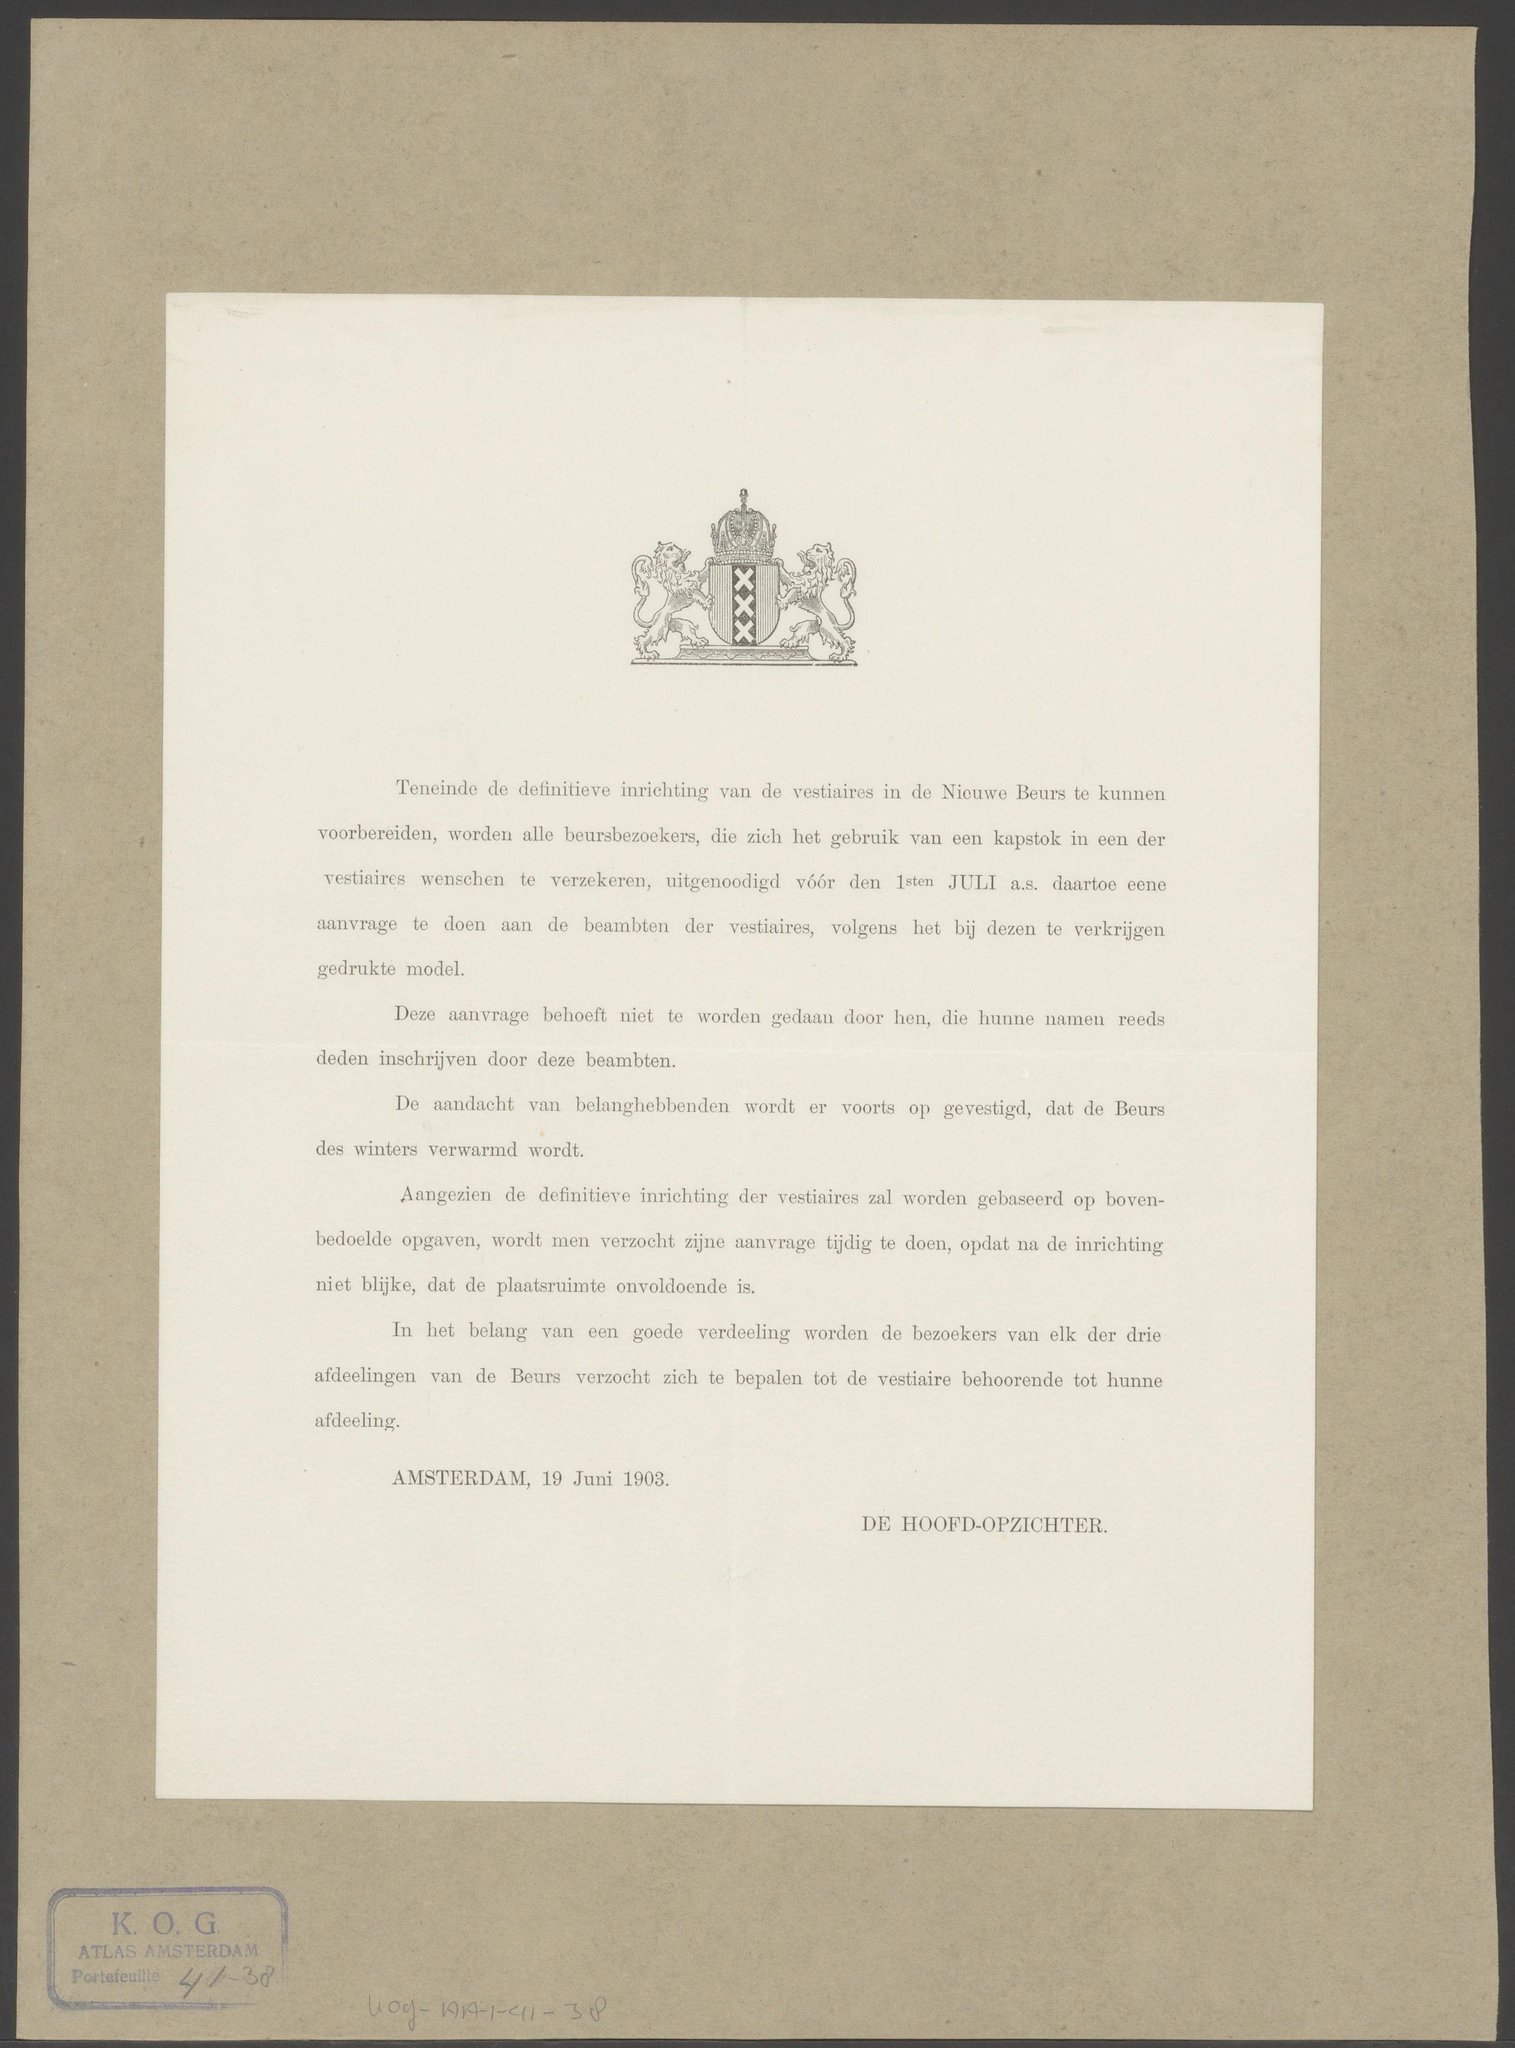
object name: text sheet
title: Verzoek tot aanvragen van kapstokken in de Beurs van Berlage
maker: Anonymous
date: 1903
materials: paper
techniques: letterpress printing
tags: stock exchange, stock-market, amsterdam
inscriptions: collector's mark: Lugt 1461b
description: Onderwerpsrubriek binnen de Atlas Amsterdam: B. Beurs op het Damrak.